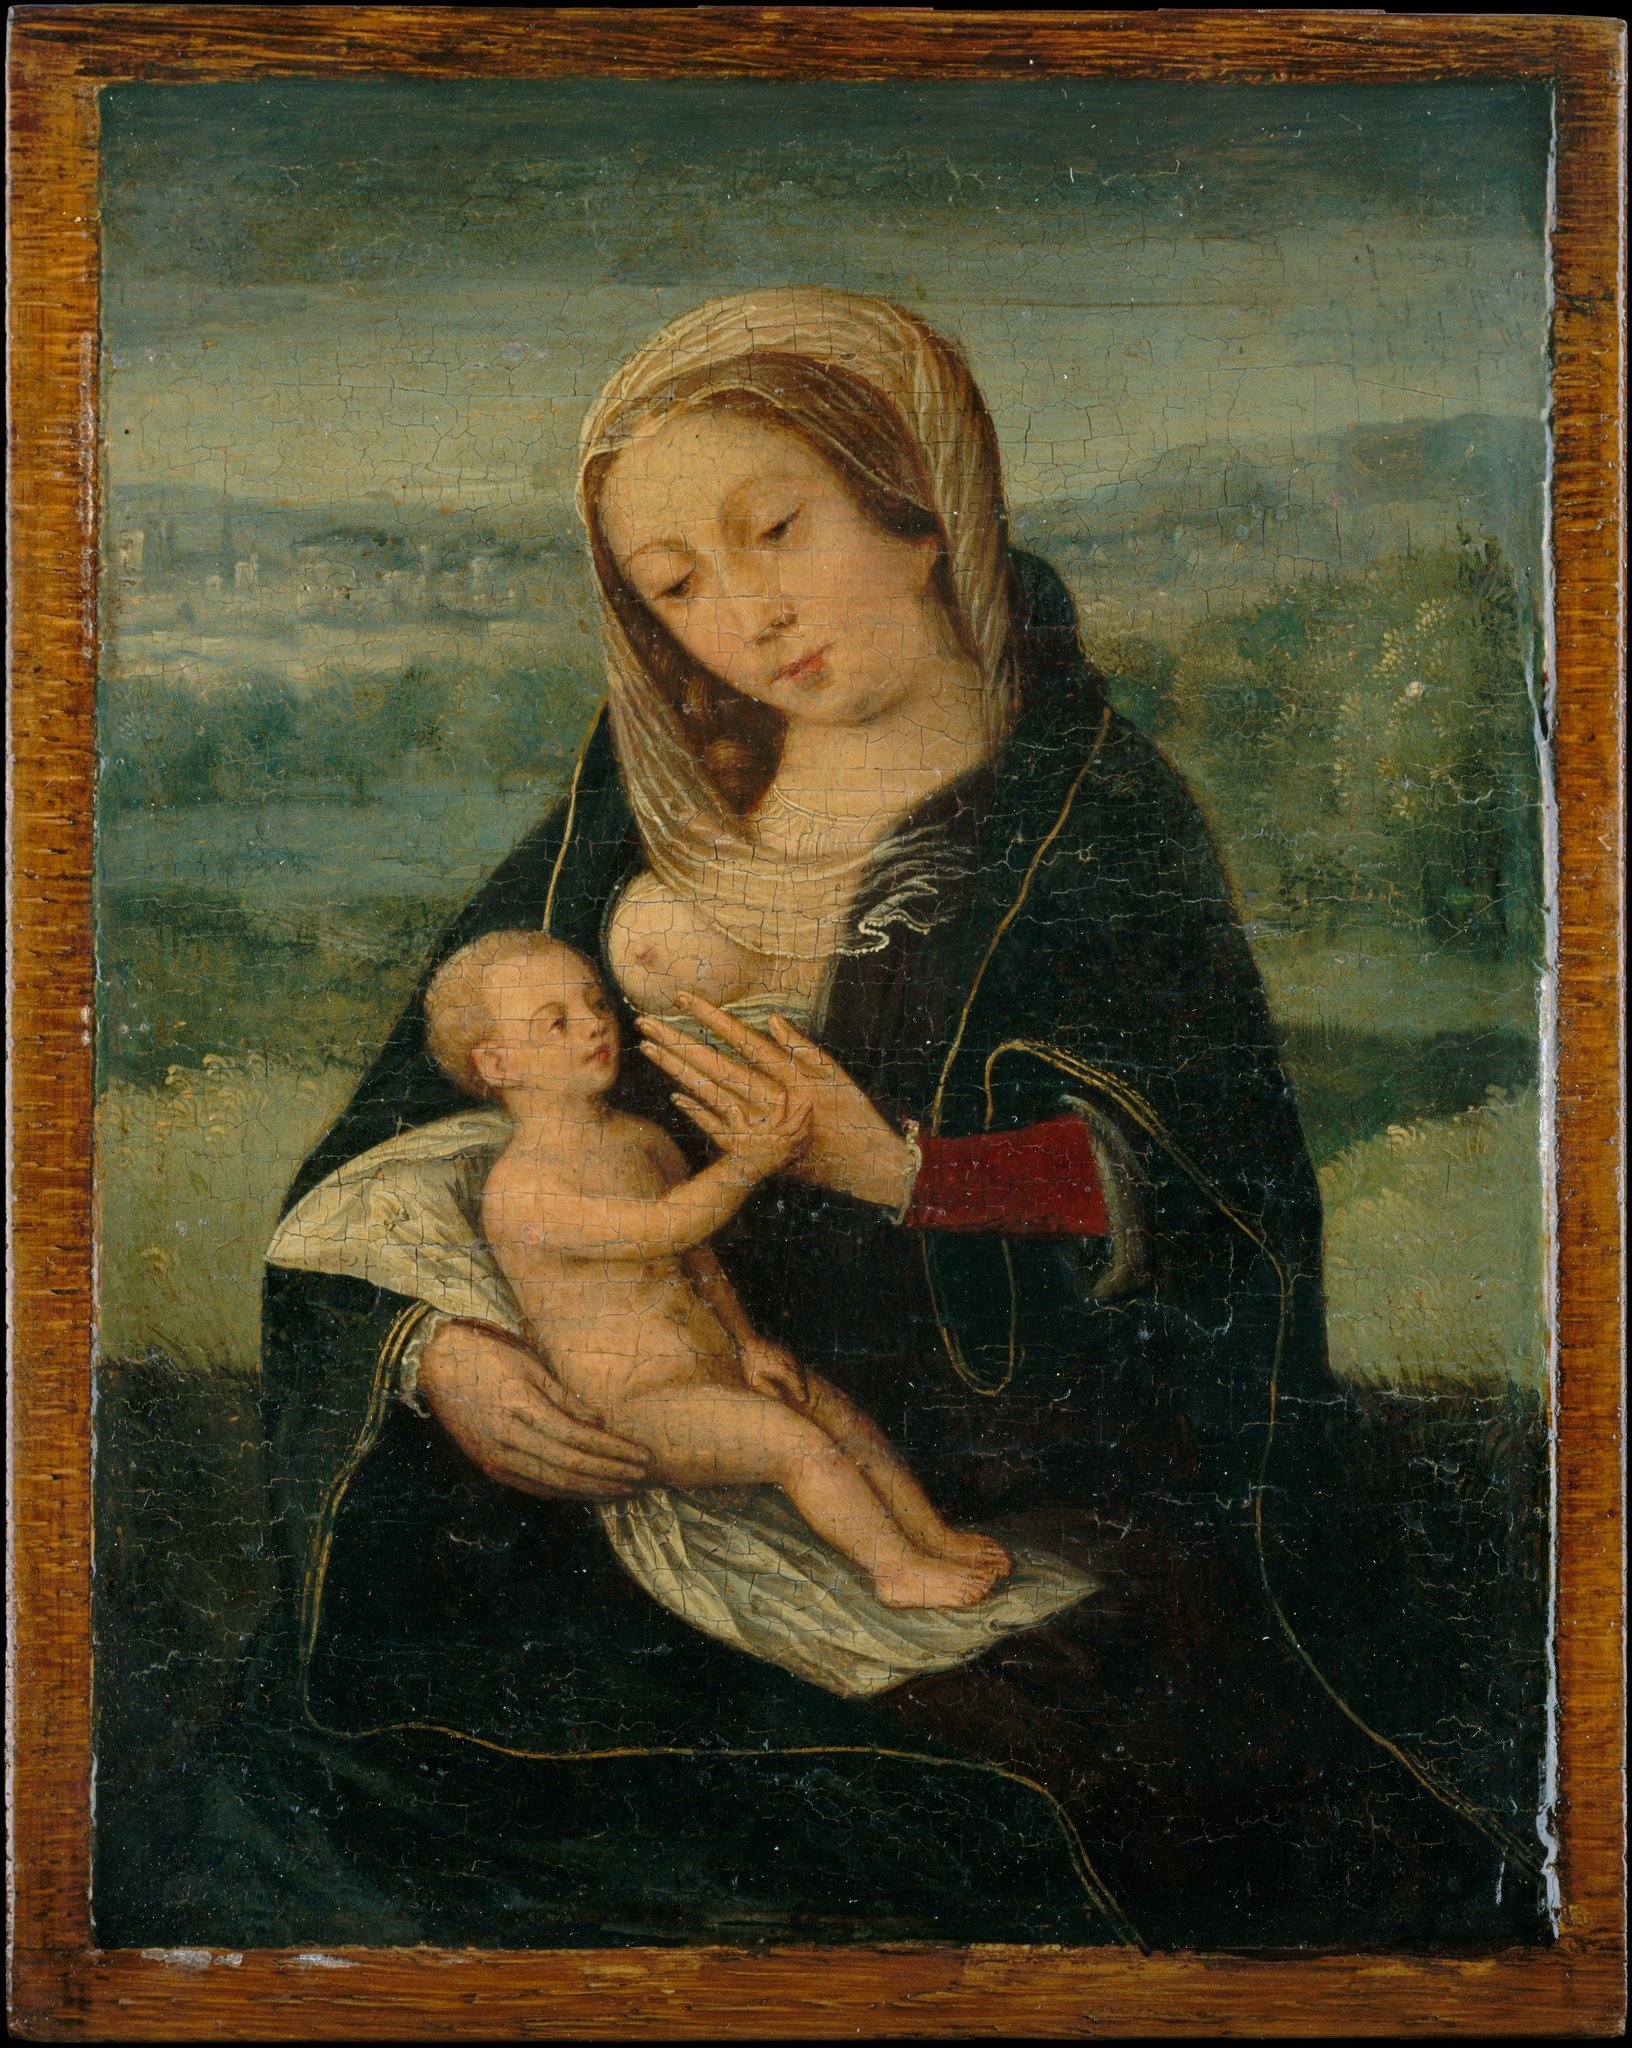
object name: painting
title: Virgin and Child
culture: dutch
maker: netherlandish (antwerp?)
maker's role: artist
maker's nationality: netherlandish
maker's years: 1525-1549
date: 1526-1550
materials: oil, wood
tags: madonna and child